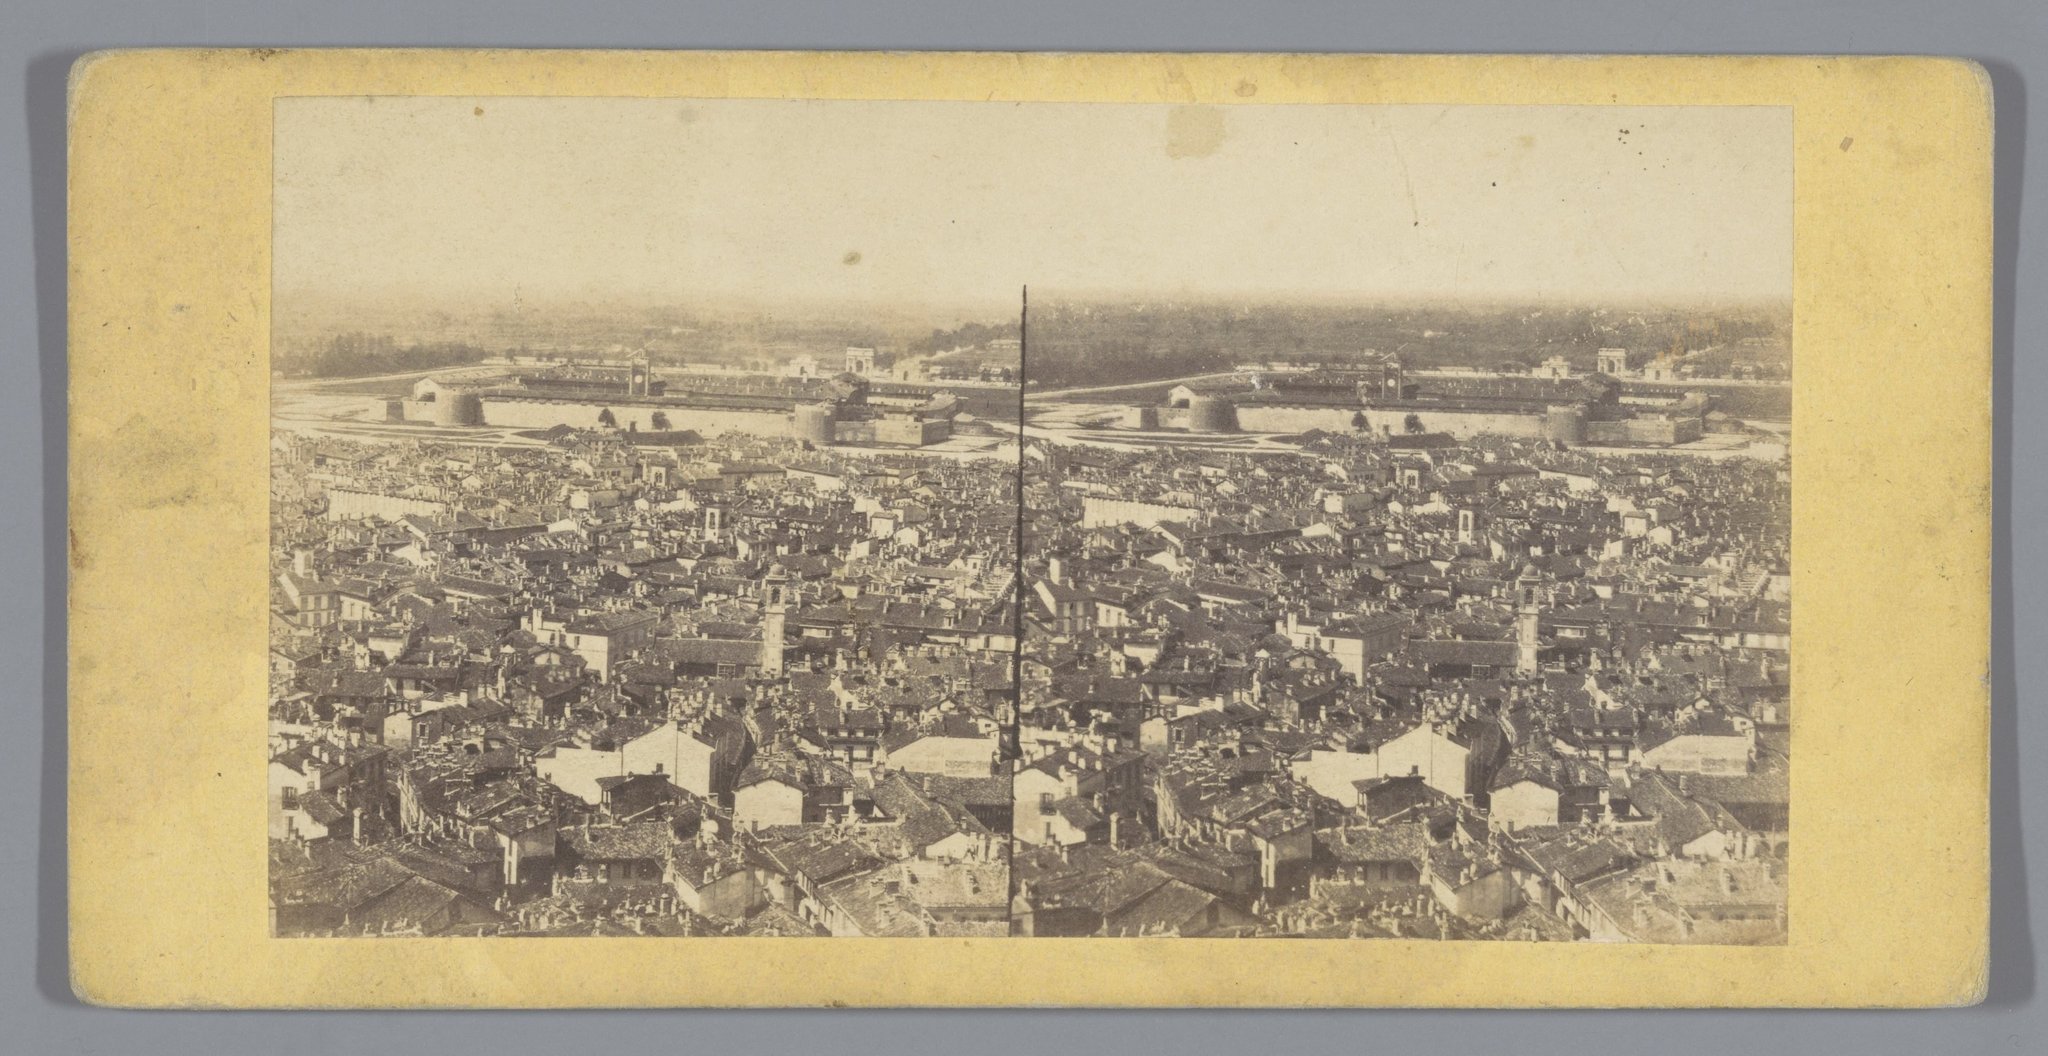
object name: stereograph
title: Gezicht op Milaan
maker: Anonymous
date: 1850-1880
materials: cardboard, photographic support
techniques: albumen print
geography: milan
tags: city-view in general; 'veduta'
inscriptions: inscription: ‘Panorama con veduta del Castello Milano’